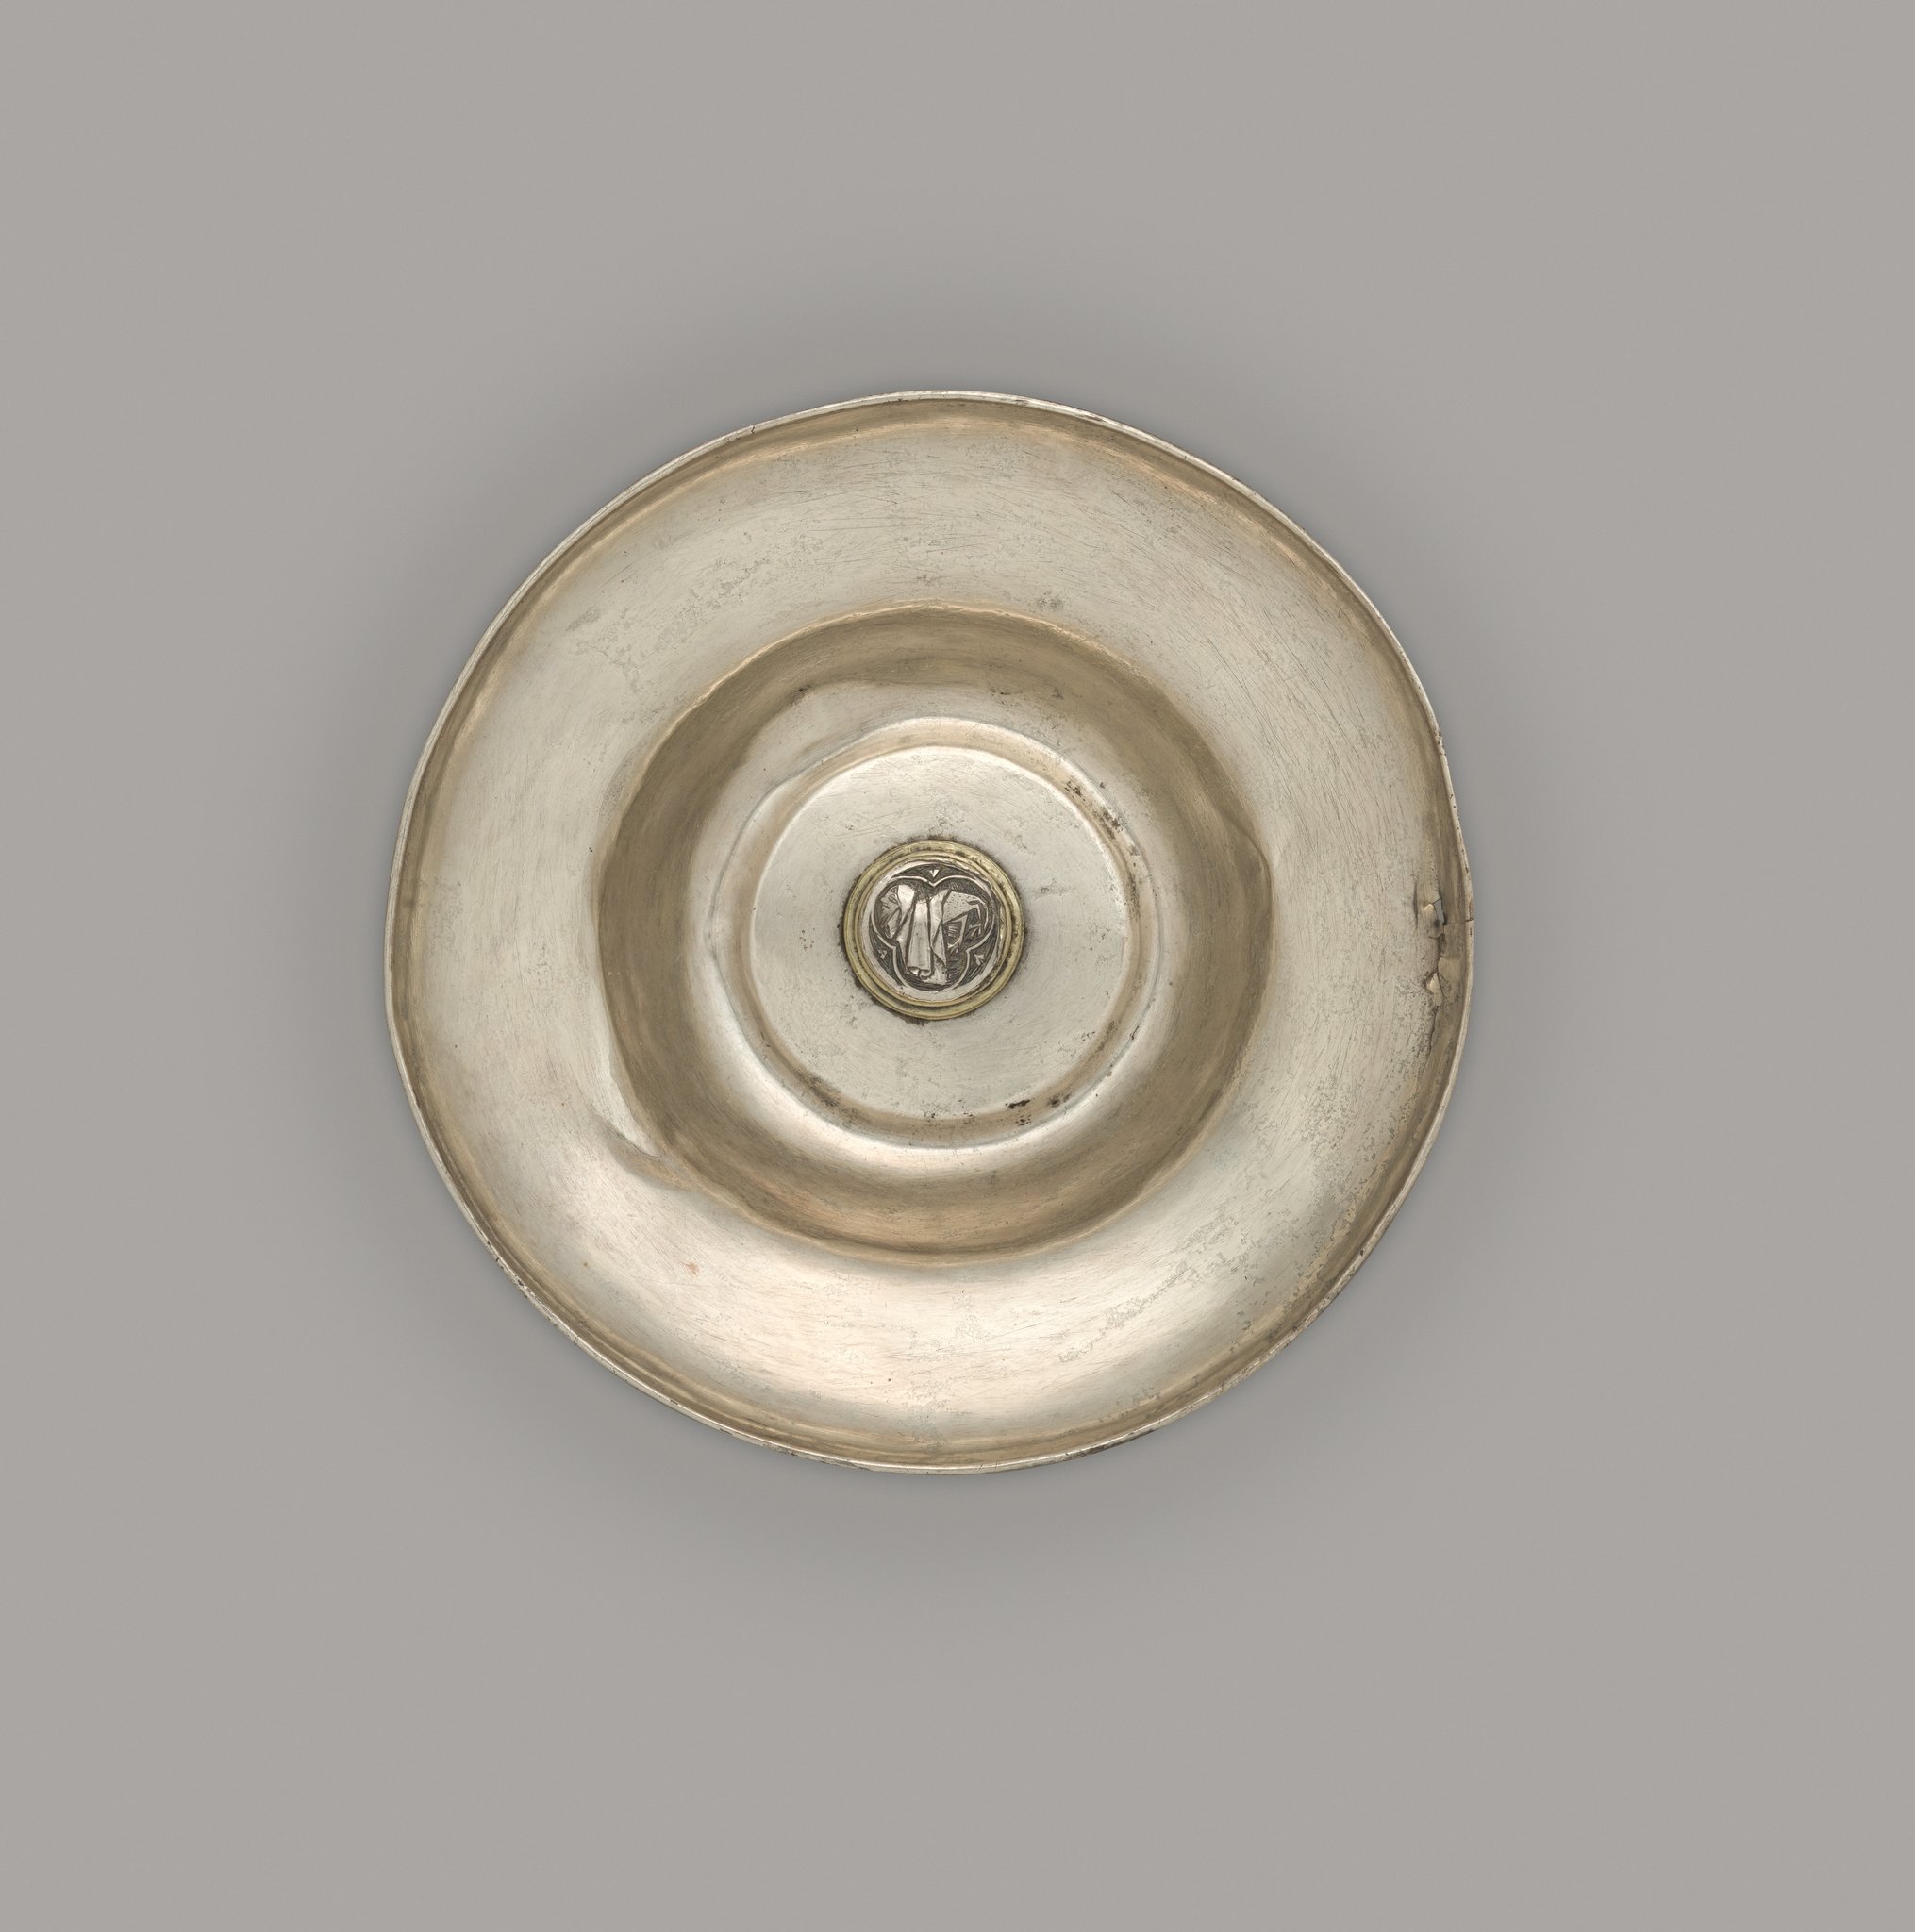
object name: drinking vessel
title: Drinking Vessel (Hanap; one of a pair)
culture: french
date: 1320-1360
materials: enamel, silver, silver gilt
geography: france